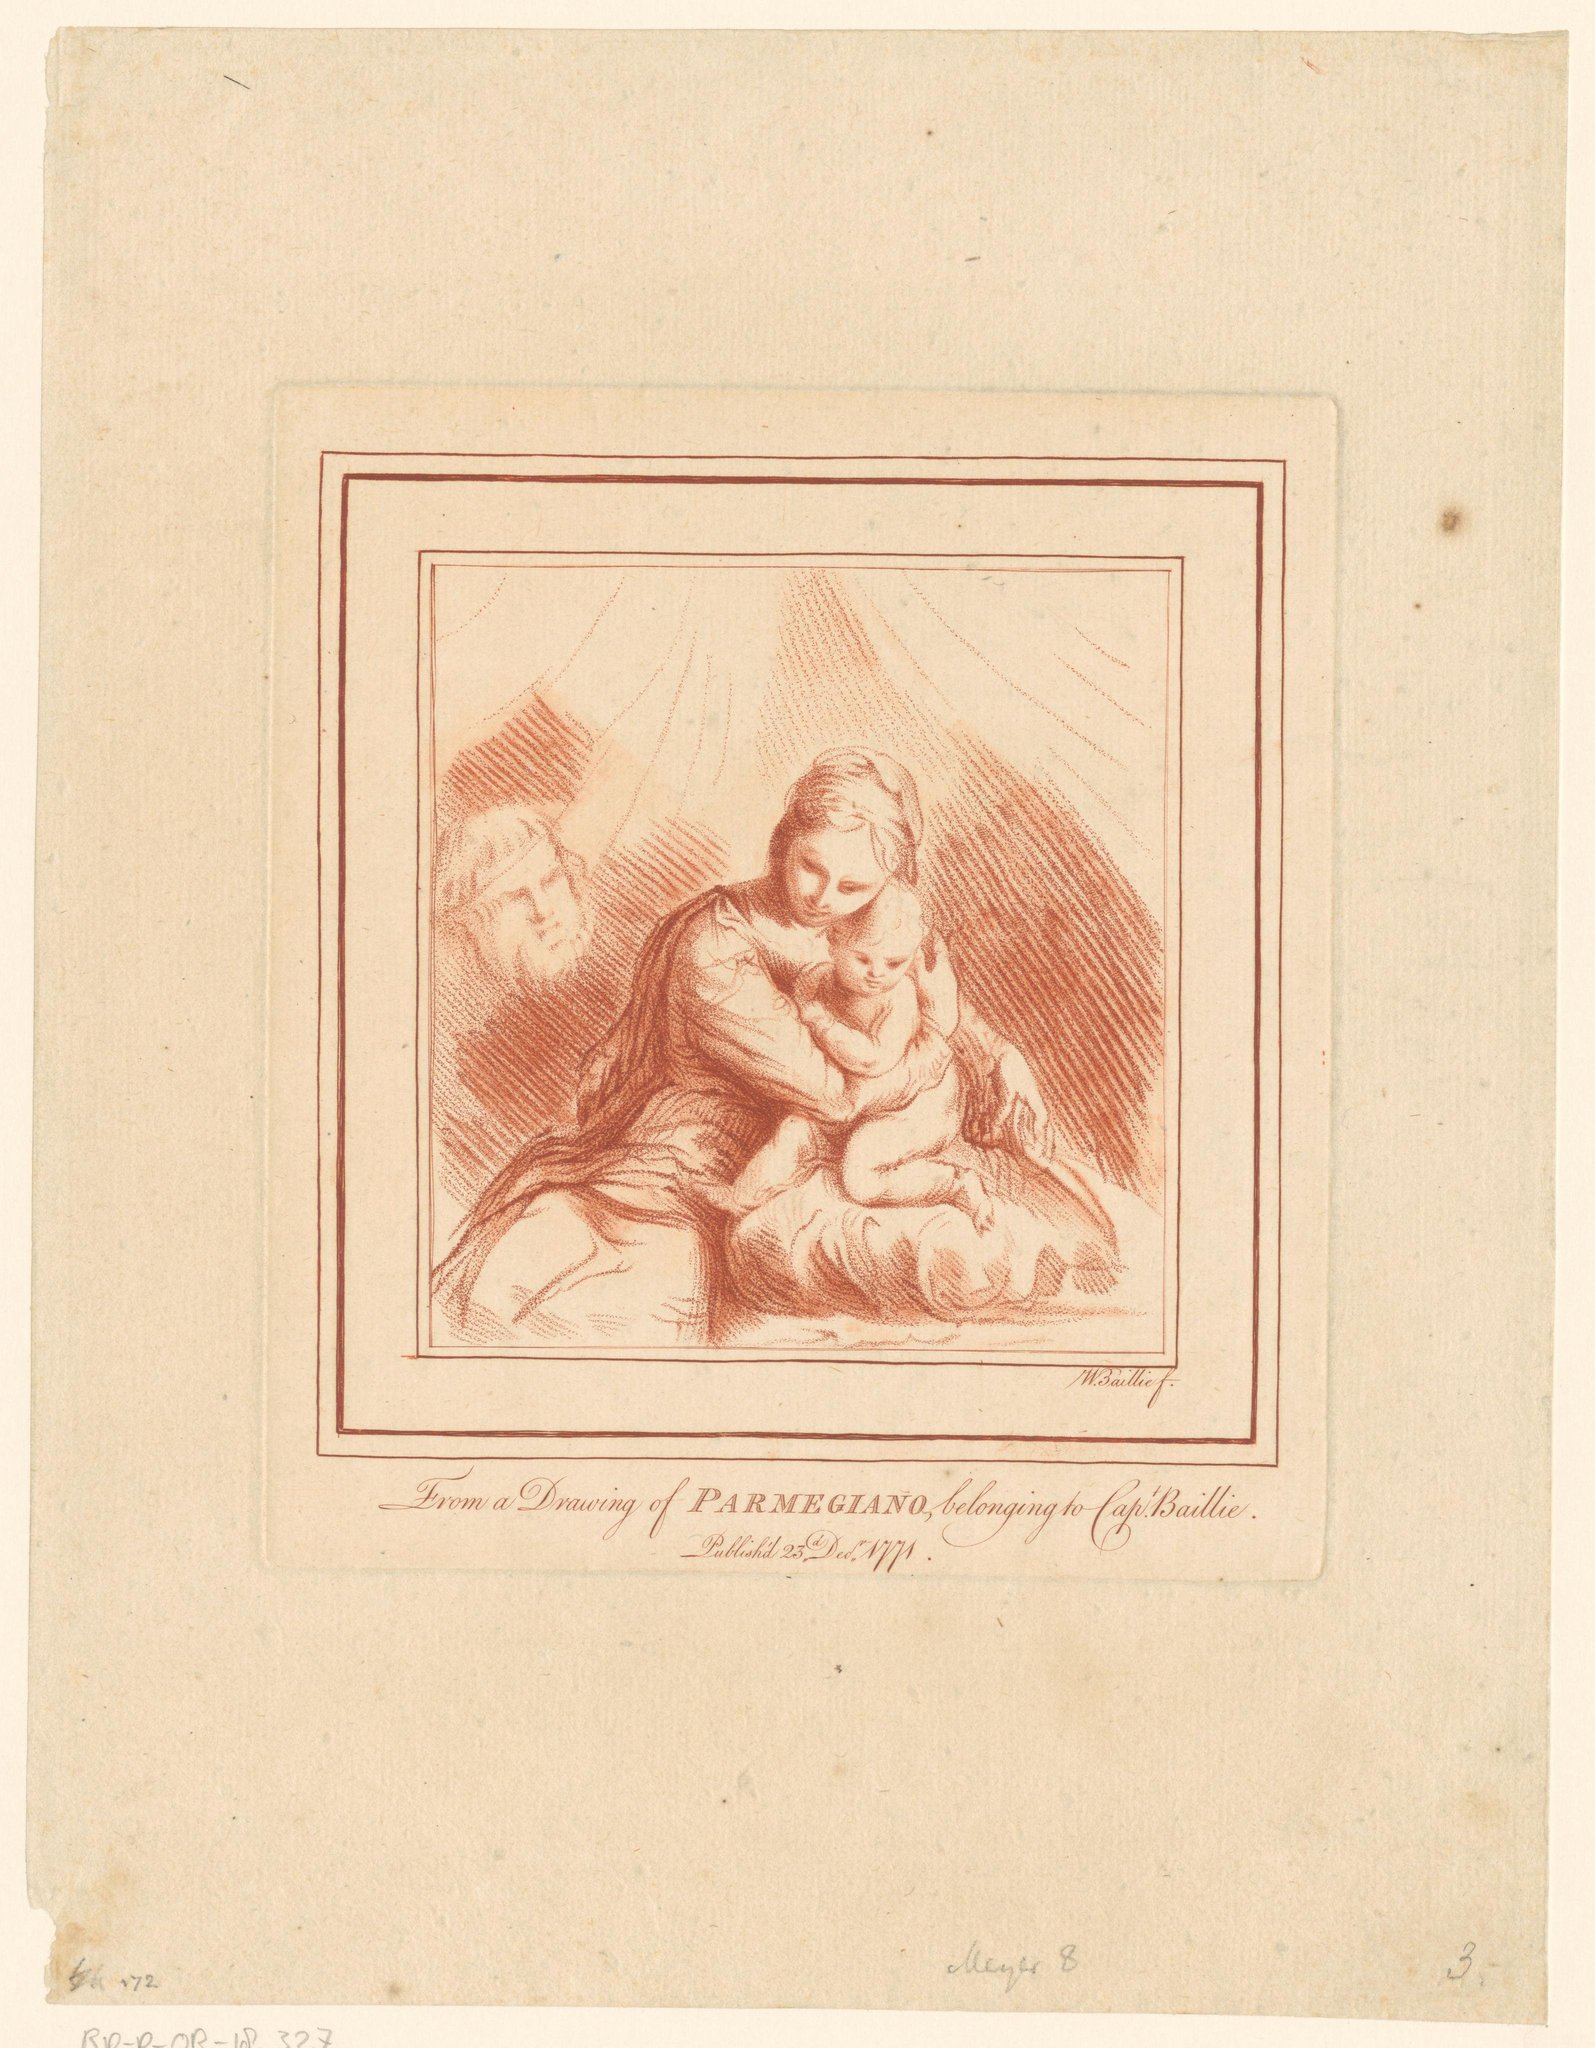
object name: print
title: Heilige Familie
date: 1712-1771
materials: paper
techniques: printmaking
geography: england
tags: madonna: i.e. mary with the christ-child, holy family, and derived representations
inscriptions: collector's mark: Lugt 240